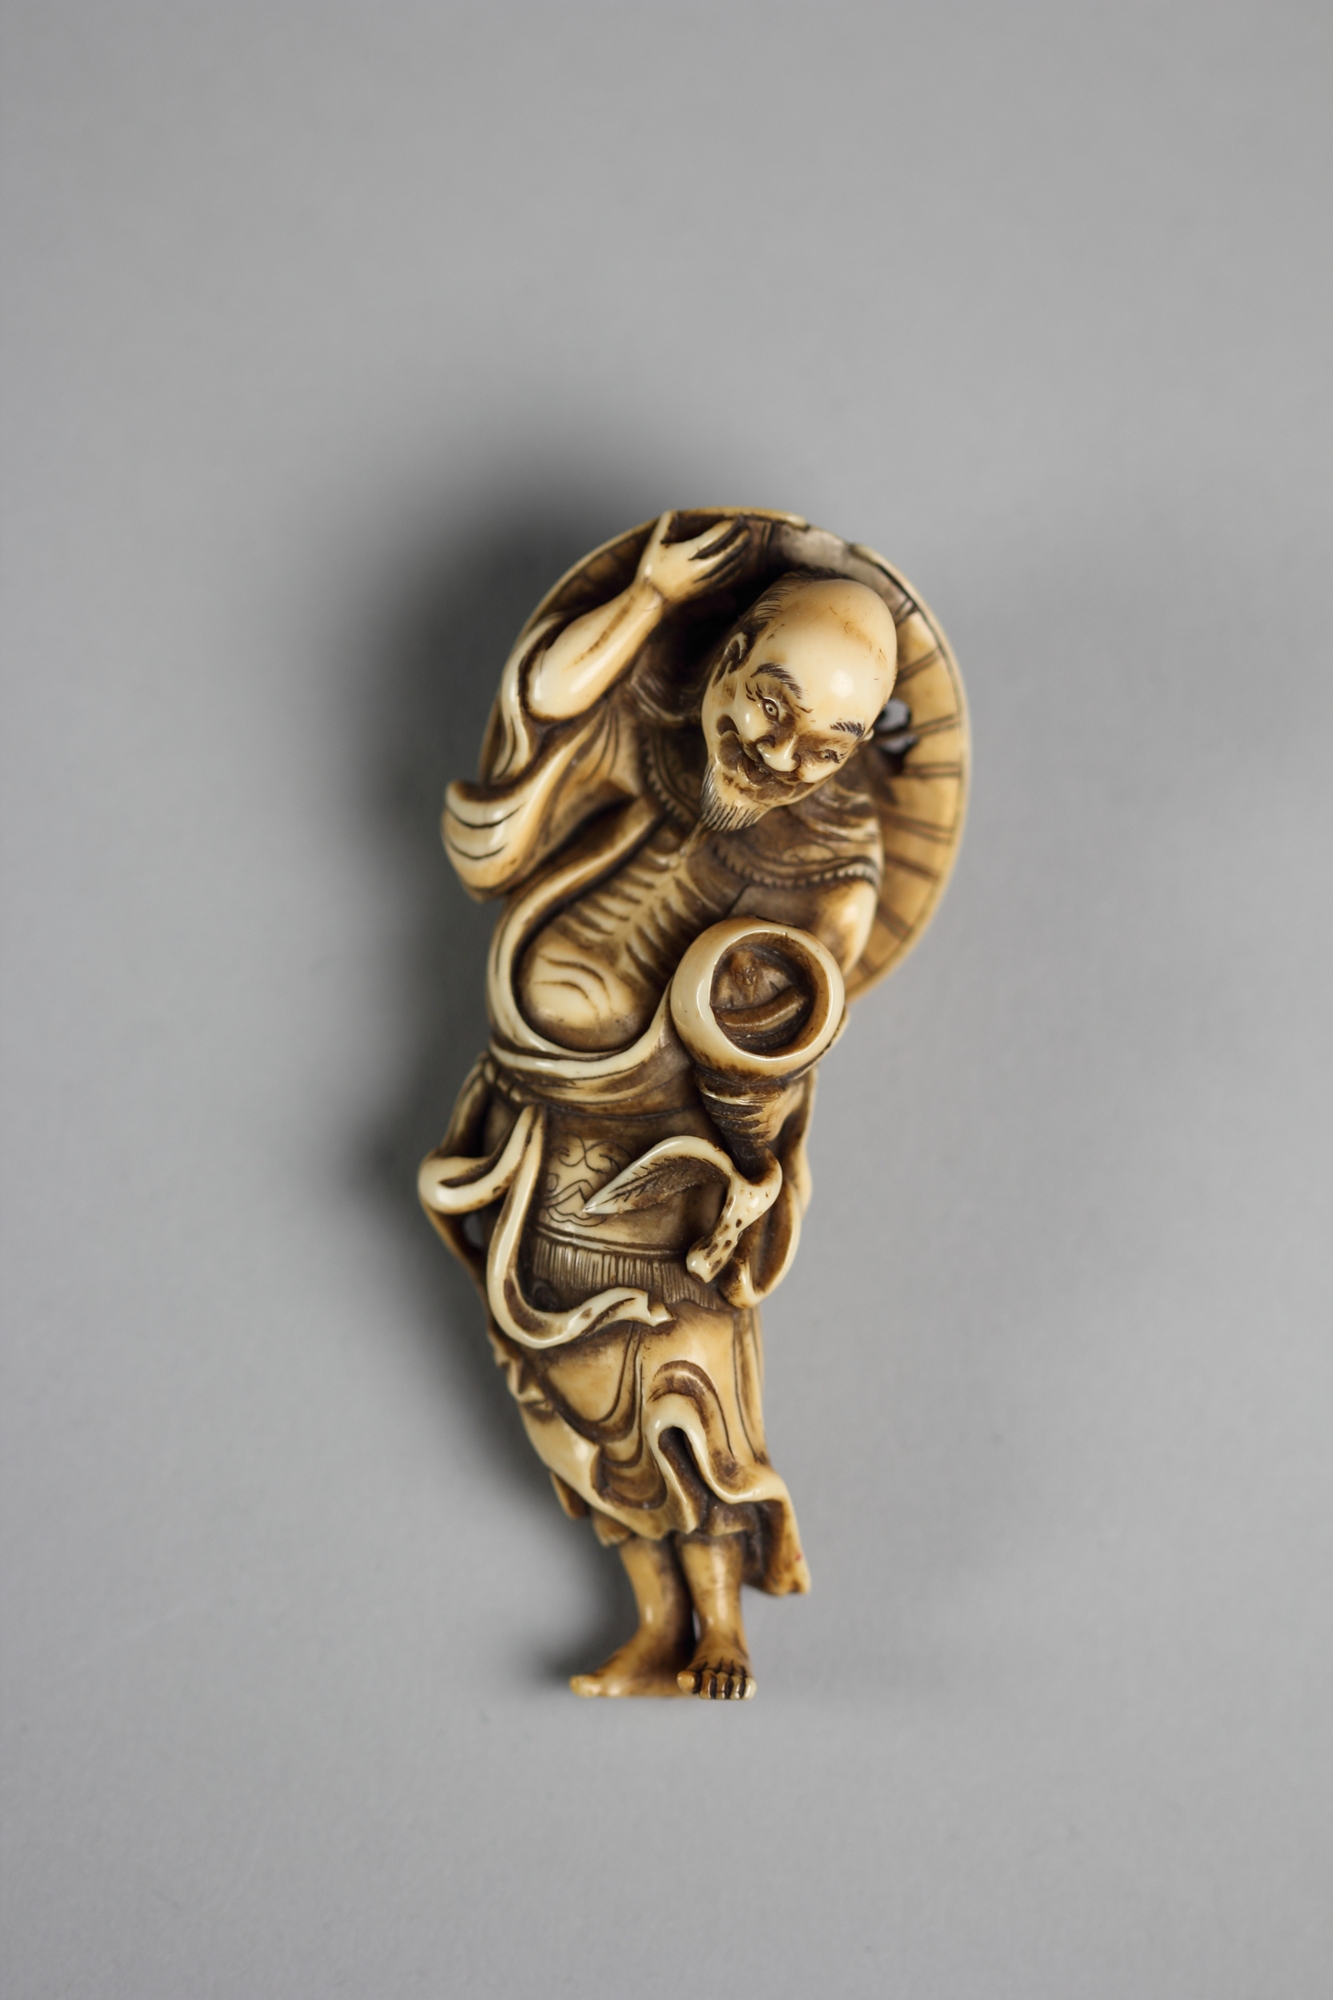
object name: netsuke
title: Daoist Immortal Tōbōsaku Sennin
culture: japanese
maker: ryūminsai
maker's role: artist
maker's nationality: japanese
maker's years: 1767-1833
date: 1767-1833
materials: ivory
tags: daoism